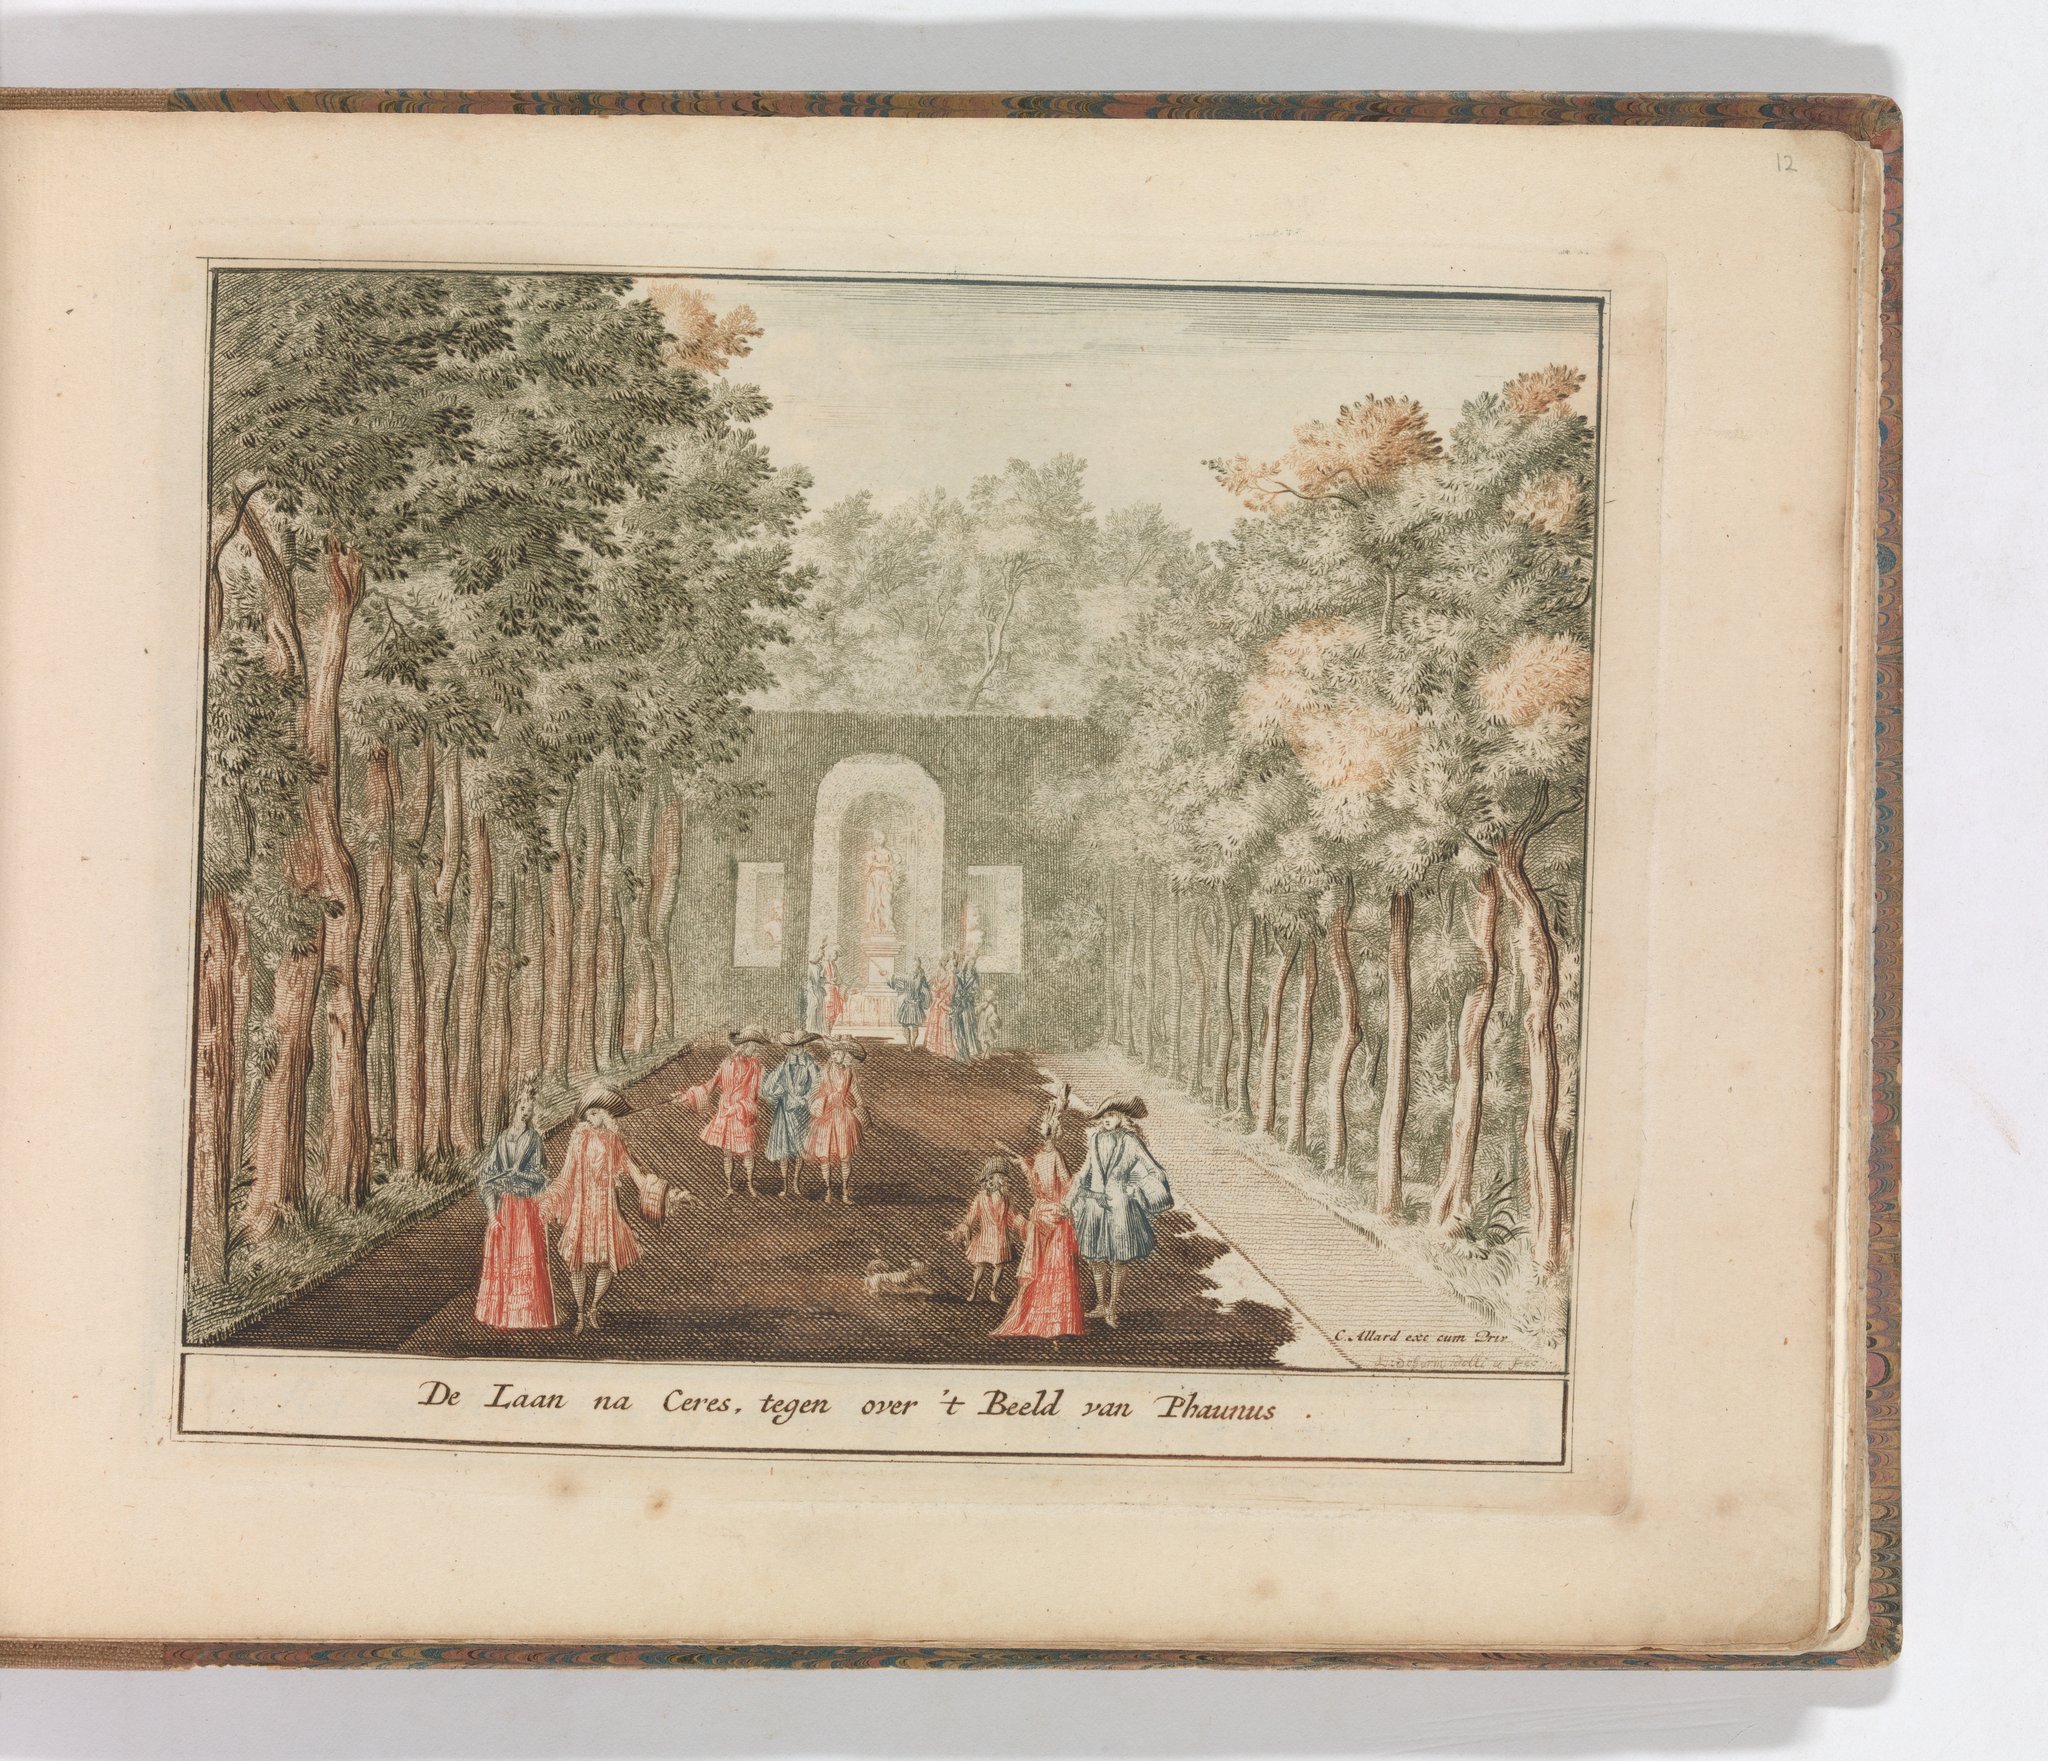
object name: book print ornament architecture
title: 'De Laan na Ceres, tegen over 't Beeld van Phaunus'', in: Tooneel Der Voornaamste Nederlands Huizen, En Lust Hoven, Naar T Leven Afgebeeld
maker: carel allard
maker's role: publisher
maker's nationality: dutch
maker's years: 1648-1709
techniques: engraving, lithography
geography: amsterdam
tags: men,women